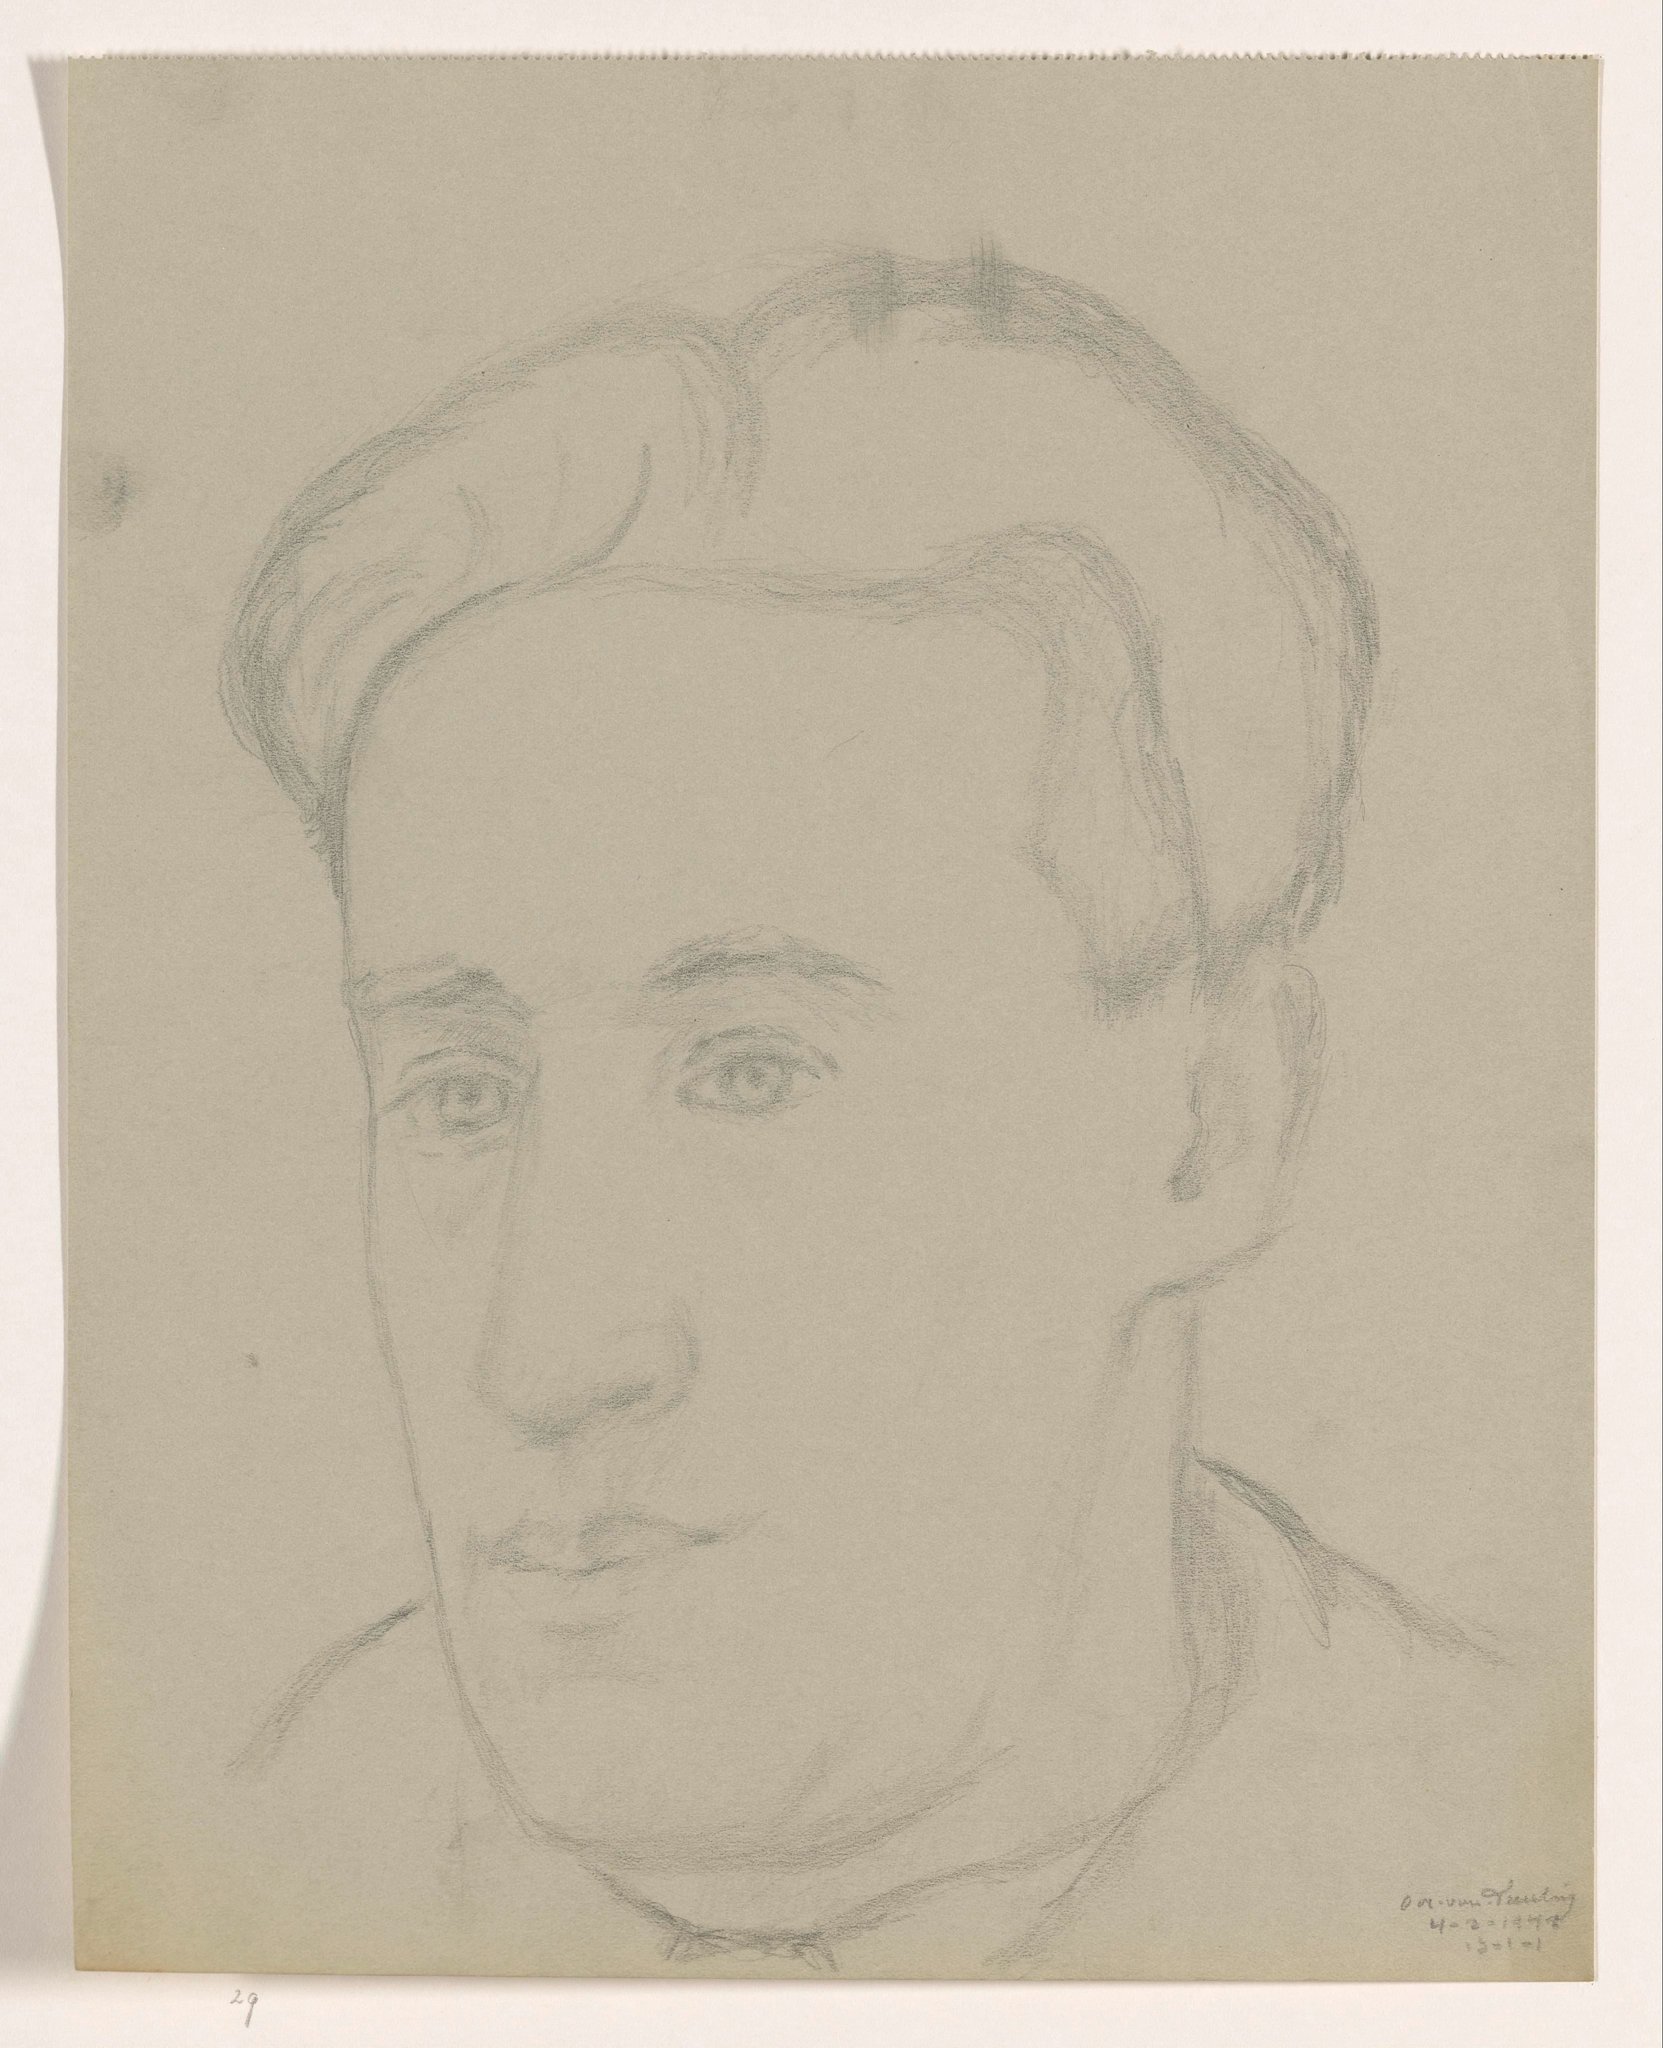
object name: drawing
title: Zelfportretten van Cor van Teeseling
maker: cor van teeseling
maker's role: draughtsman, sculptor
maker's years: 1915-1942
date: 1942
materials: paper, pencil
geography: weteringschans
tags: amsterdam, draughtsman, sculptor, cor van teeseling, historical persons, prisoner in cell or locked place, portrait, self-portrait of draughtsman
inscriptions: signature and date: ‘4-2-1942 / Cor van Teeseling / B-1-1’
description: Zelfportret van Cor van Teeseling: gevangenis aan Weteringschans, cel B-1-1, 4 februari. Getekend zelfportret van Cor van Teeseling driekwart met zijn hoofd naar links gewend.